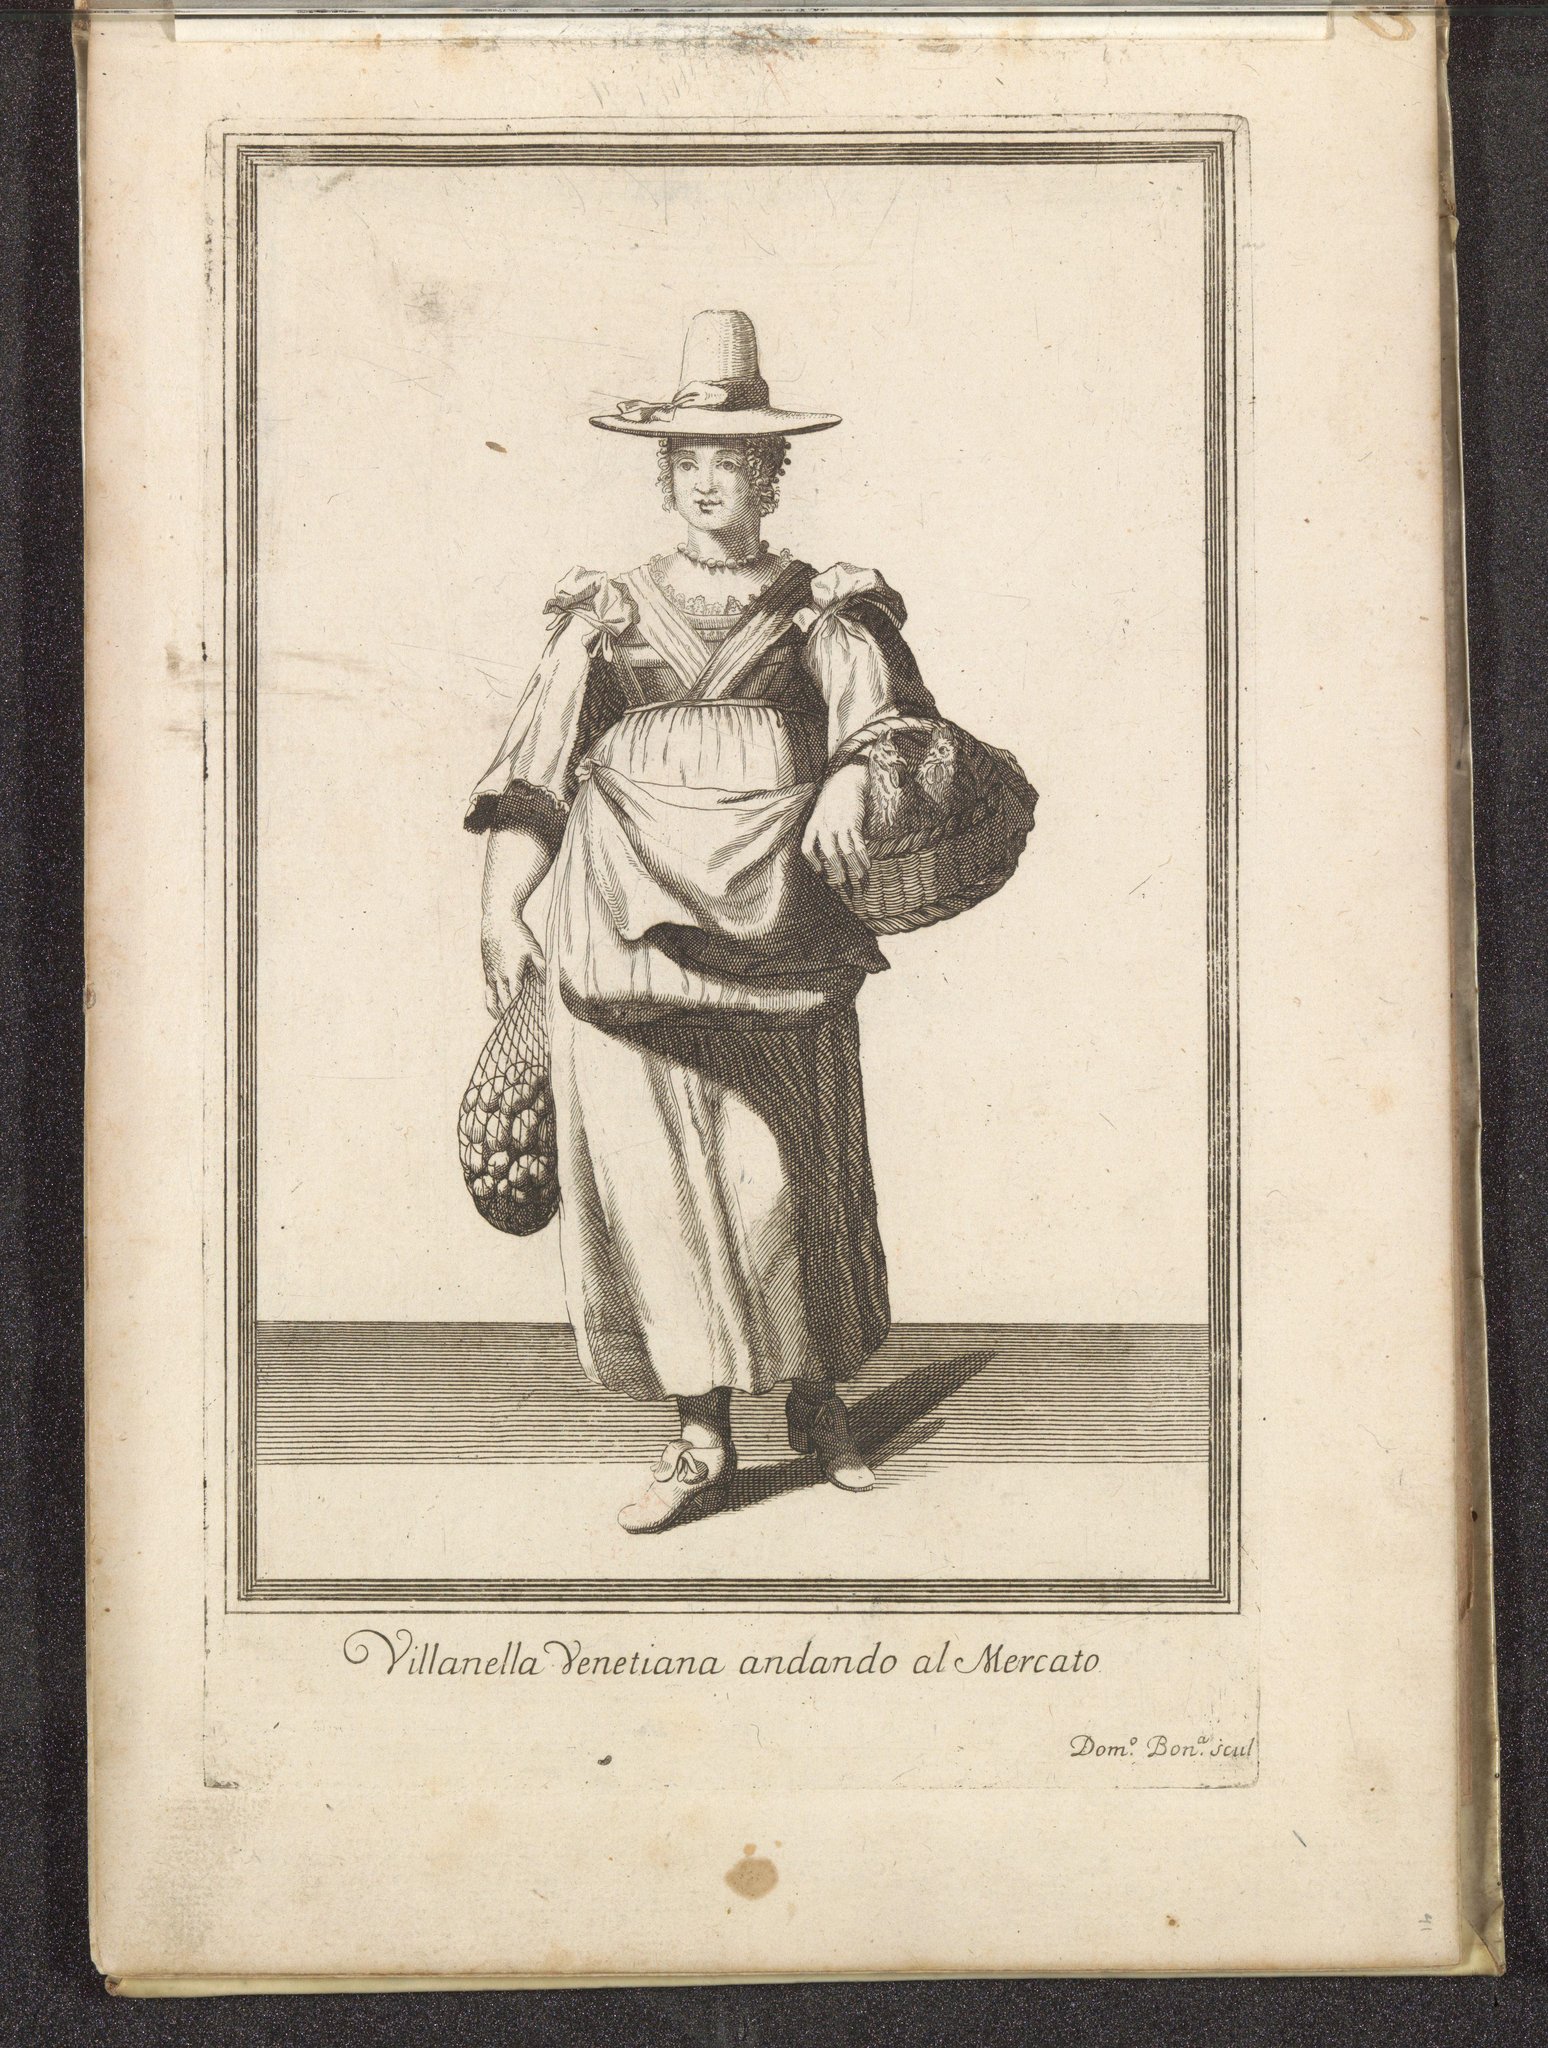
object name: print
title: Villanella Venetiana andando al Mercato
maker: domenico bonavera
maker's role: print maker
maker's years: 1640-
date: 1650-1740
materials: paper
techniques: engraving, etching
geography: italy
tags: carrying something in basket, bag, rucksack, etc., fowl (cock, hen, chicken, etc.), folk costume, regional costume, eggs, egg-dishes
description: Staande vrouw met een mand met kippen en een net met eieren. Titel in ondermarge. De prent maakt deel uit van een album.